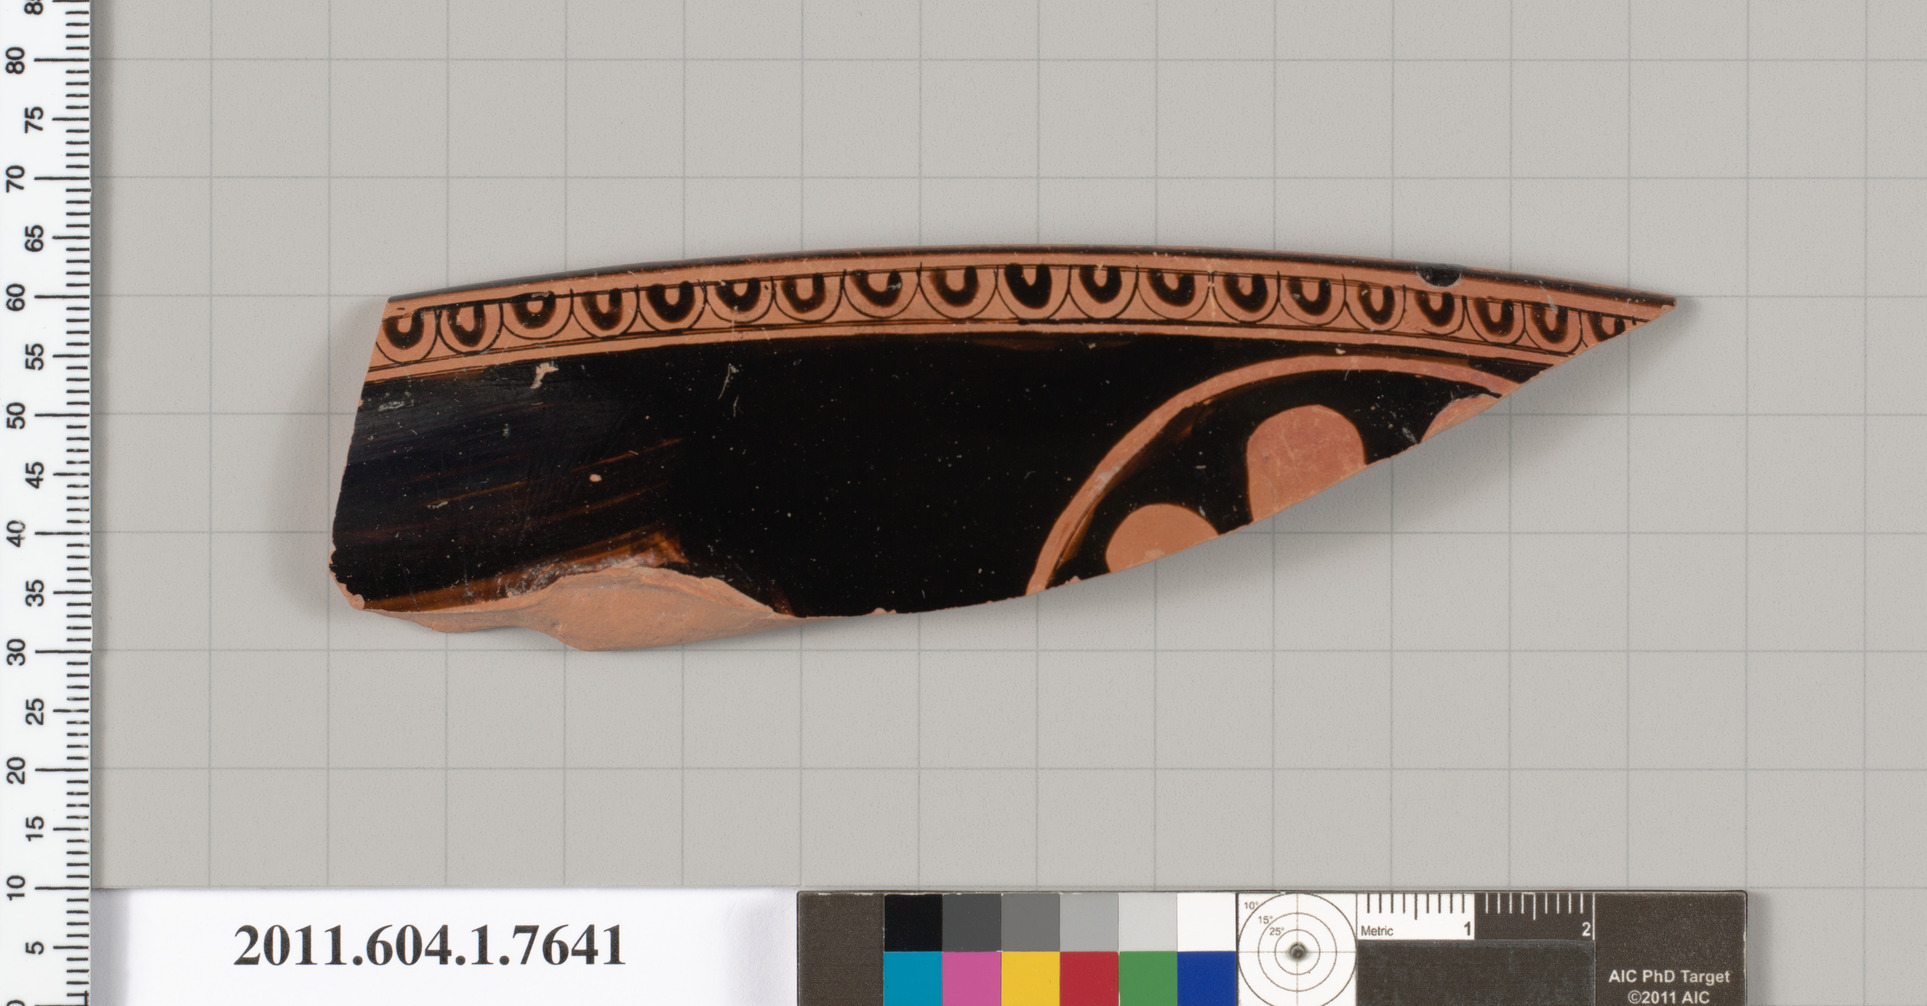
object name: kylix fragment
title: Terracotta fragment of a kylix (drinking cup)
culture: greek, attic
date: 460-450 BCE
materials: terracotta